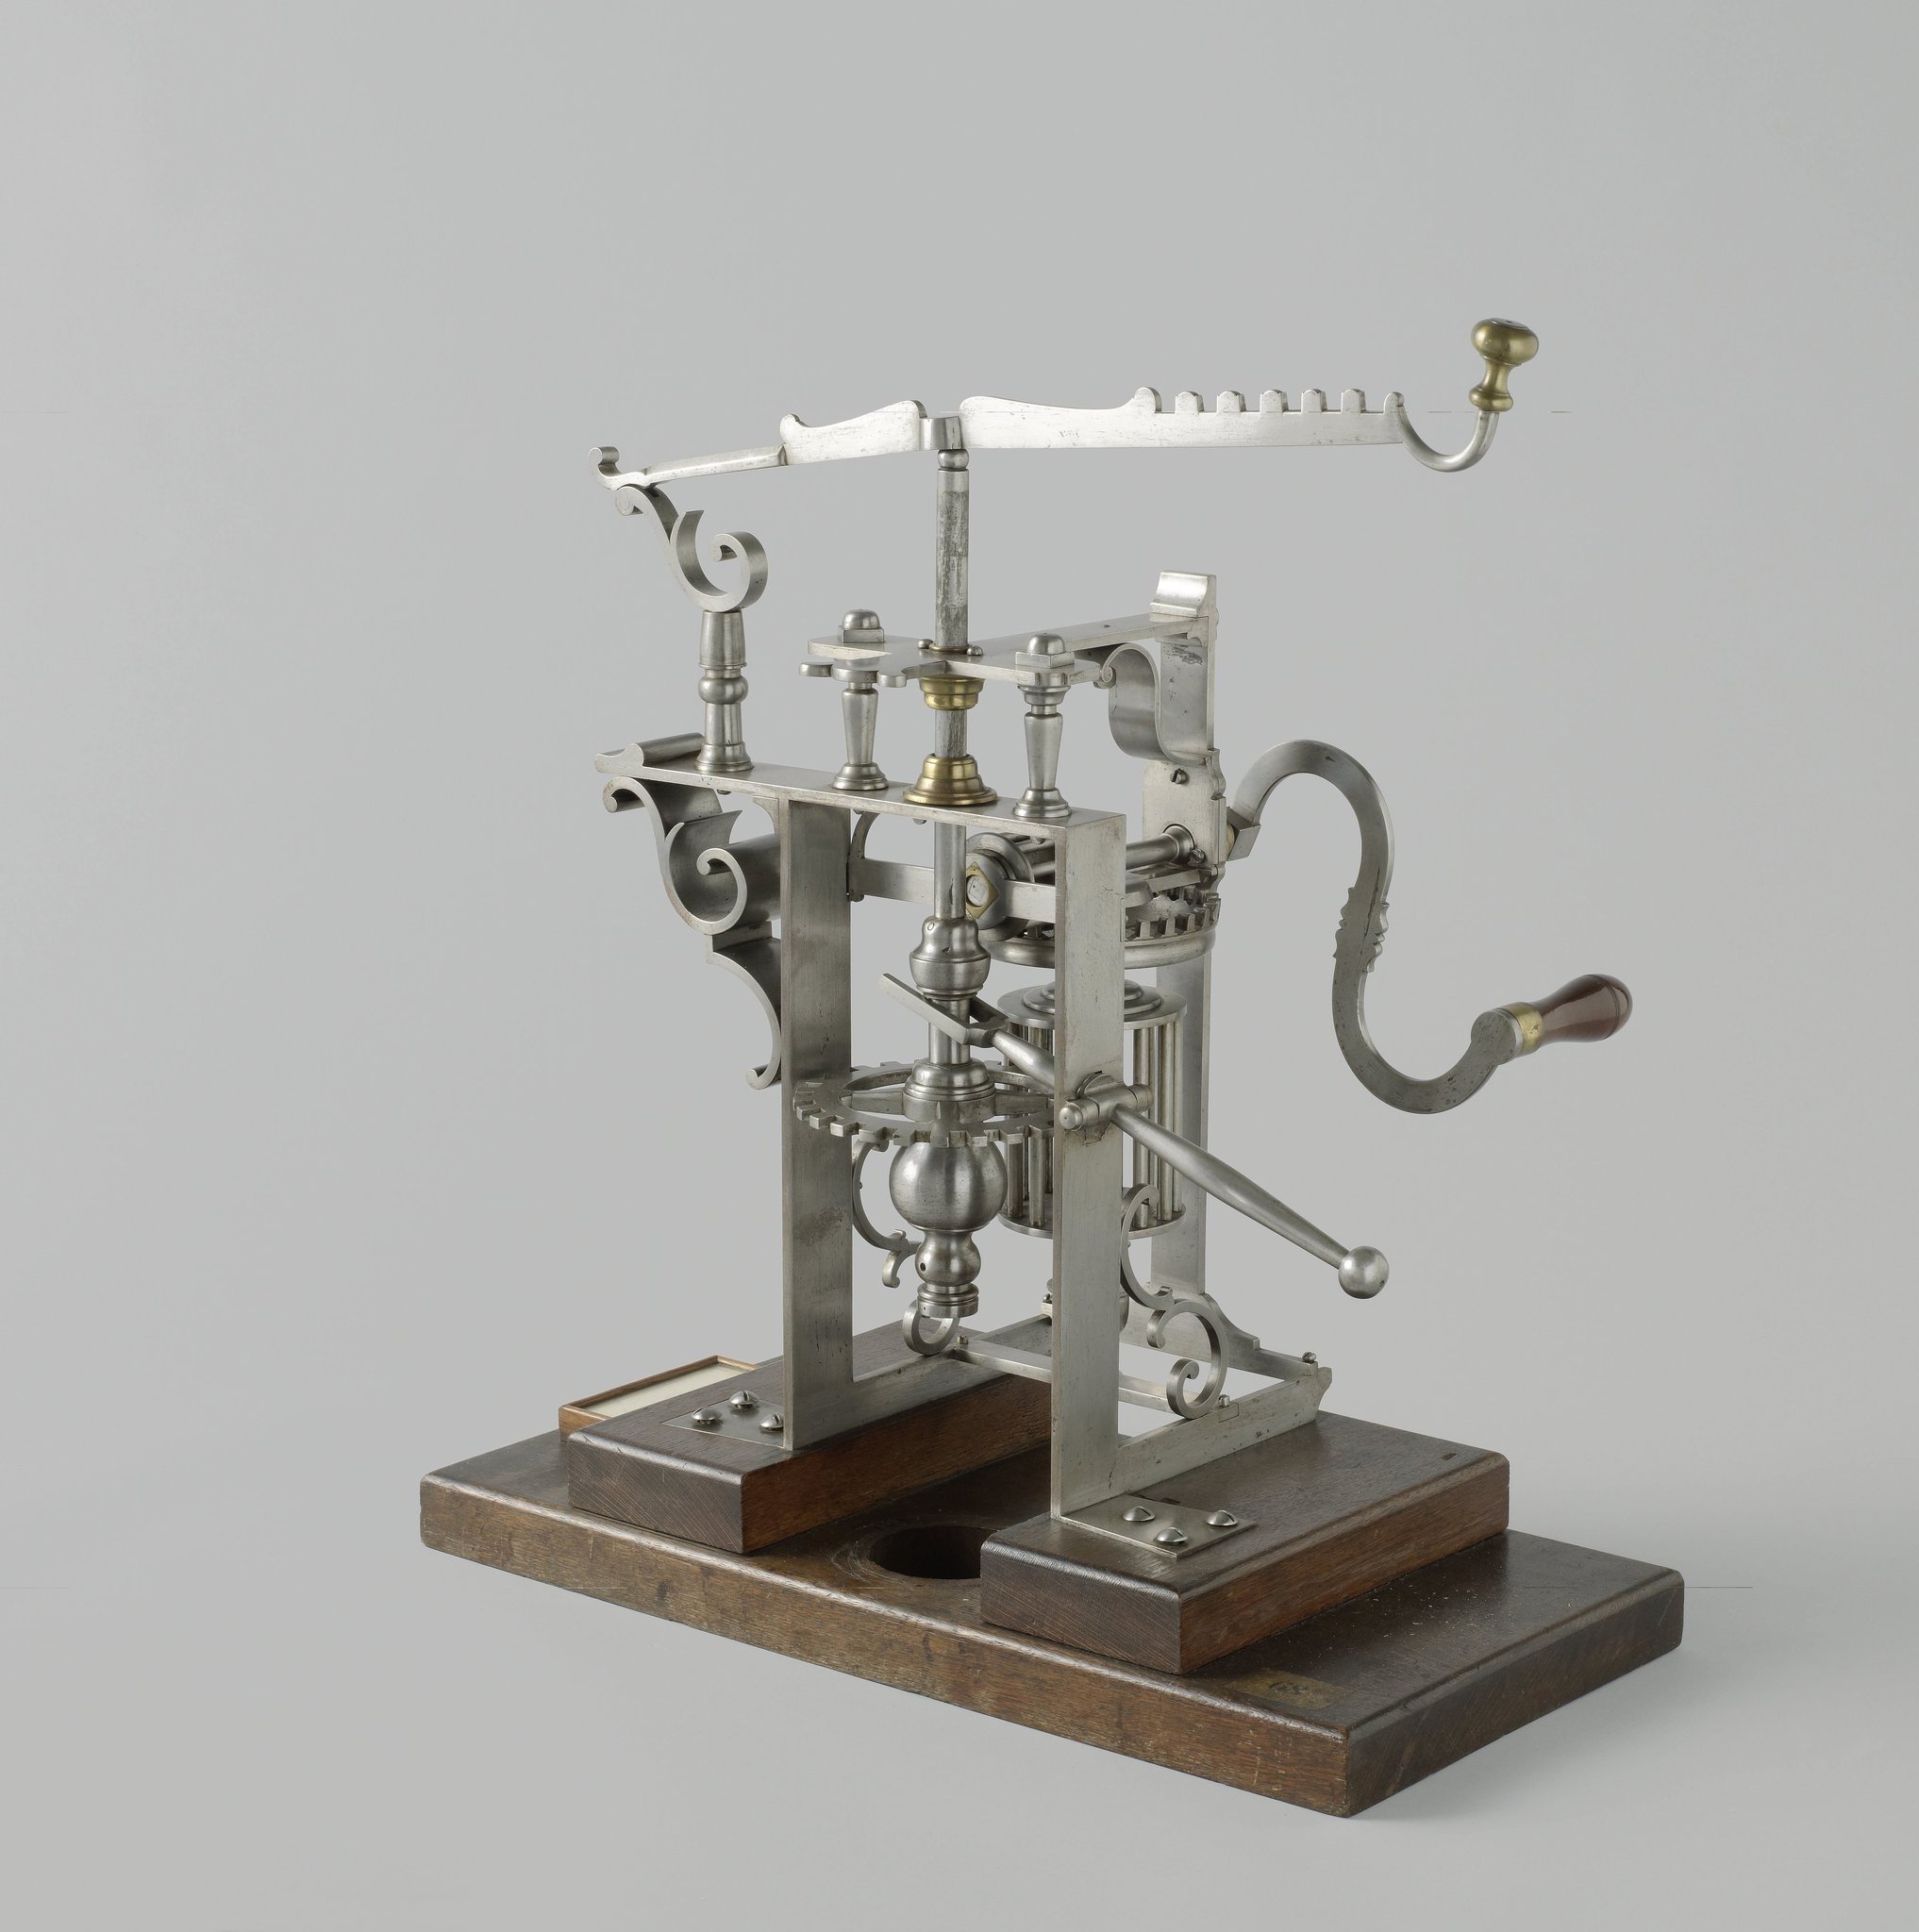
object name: drill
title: Drilling Apparatus for Metal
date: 1797-1822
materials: brass, iron, wood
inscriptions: inscription, on the base: ‘MODEL VAN EENE METAALBOORMACHINE.’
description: Fraai geornamenteerde boorstandaard op houten grondplank. De boormachine wordt met een zwengel met de hand gedreven, de overbrenging is 5:1. De boorschacht kan met een hefboom naar beneden geduwd worden, die ook met gewichten kan worden verzwaard. Een vorkvormige hefboom halverwege de schacht dient om de boor weer naar boven te bewegen. De boorkop heeft een vierkante opening voor de boortjes, die ontbreken. Onder de schacht heeft de grondplank een rond gat.